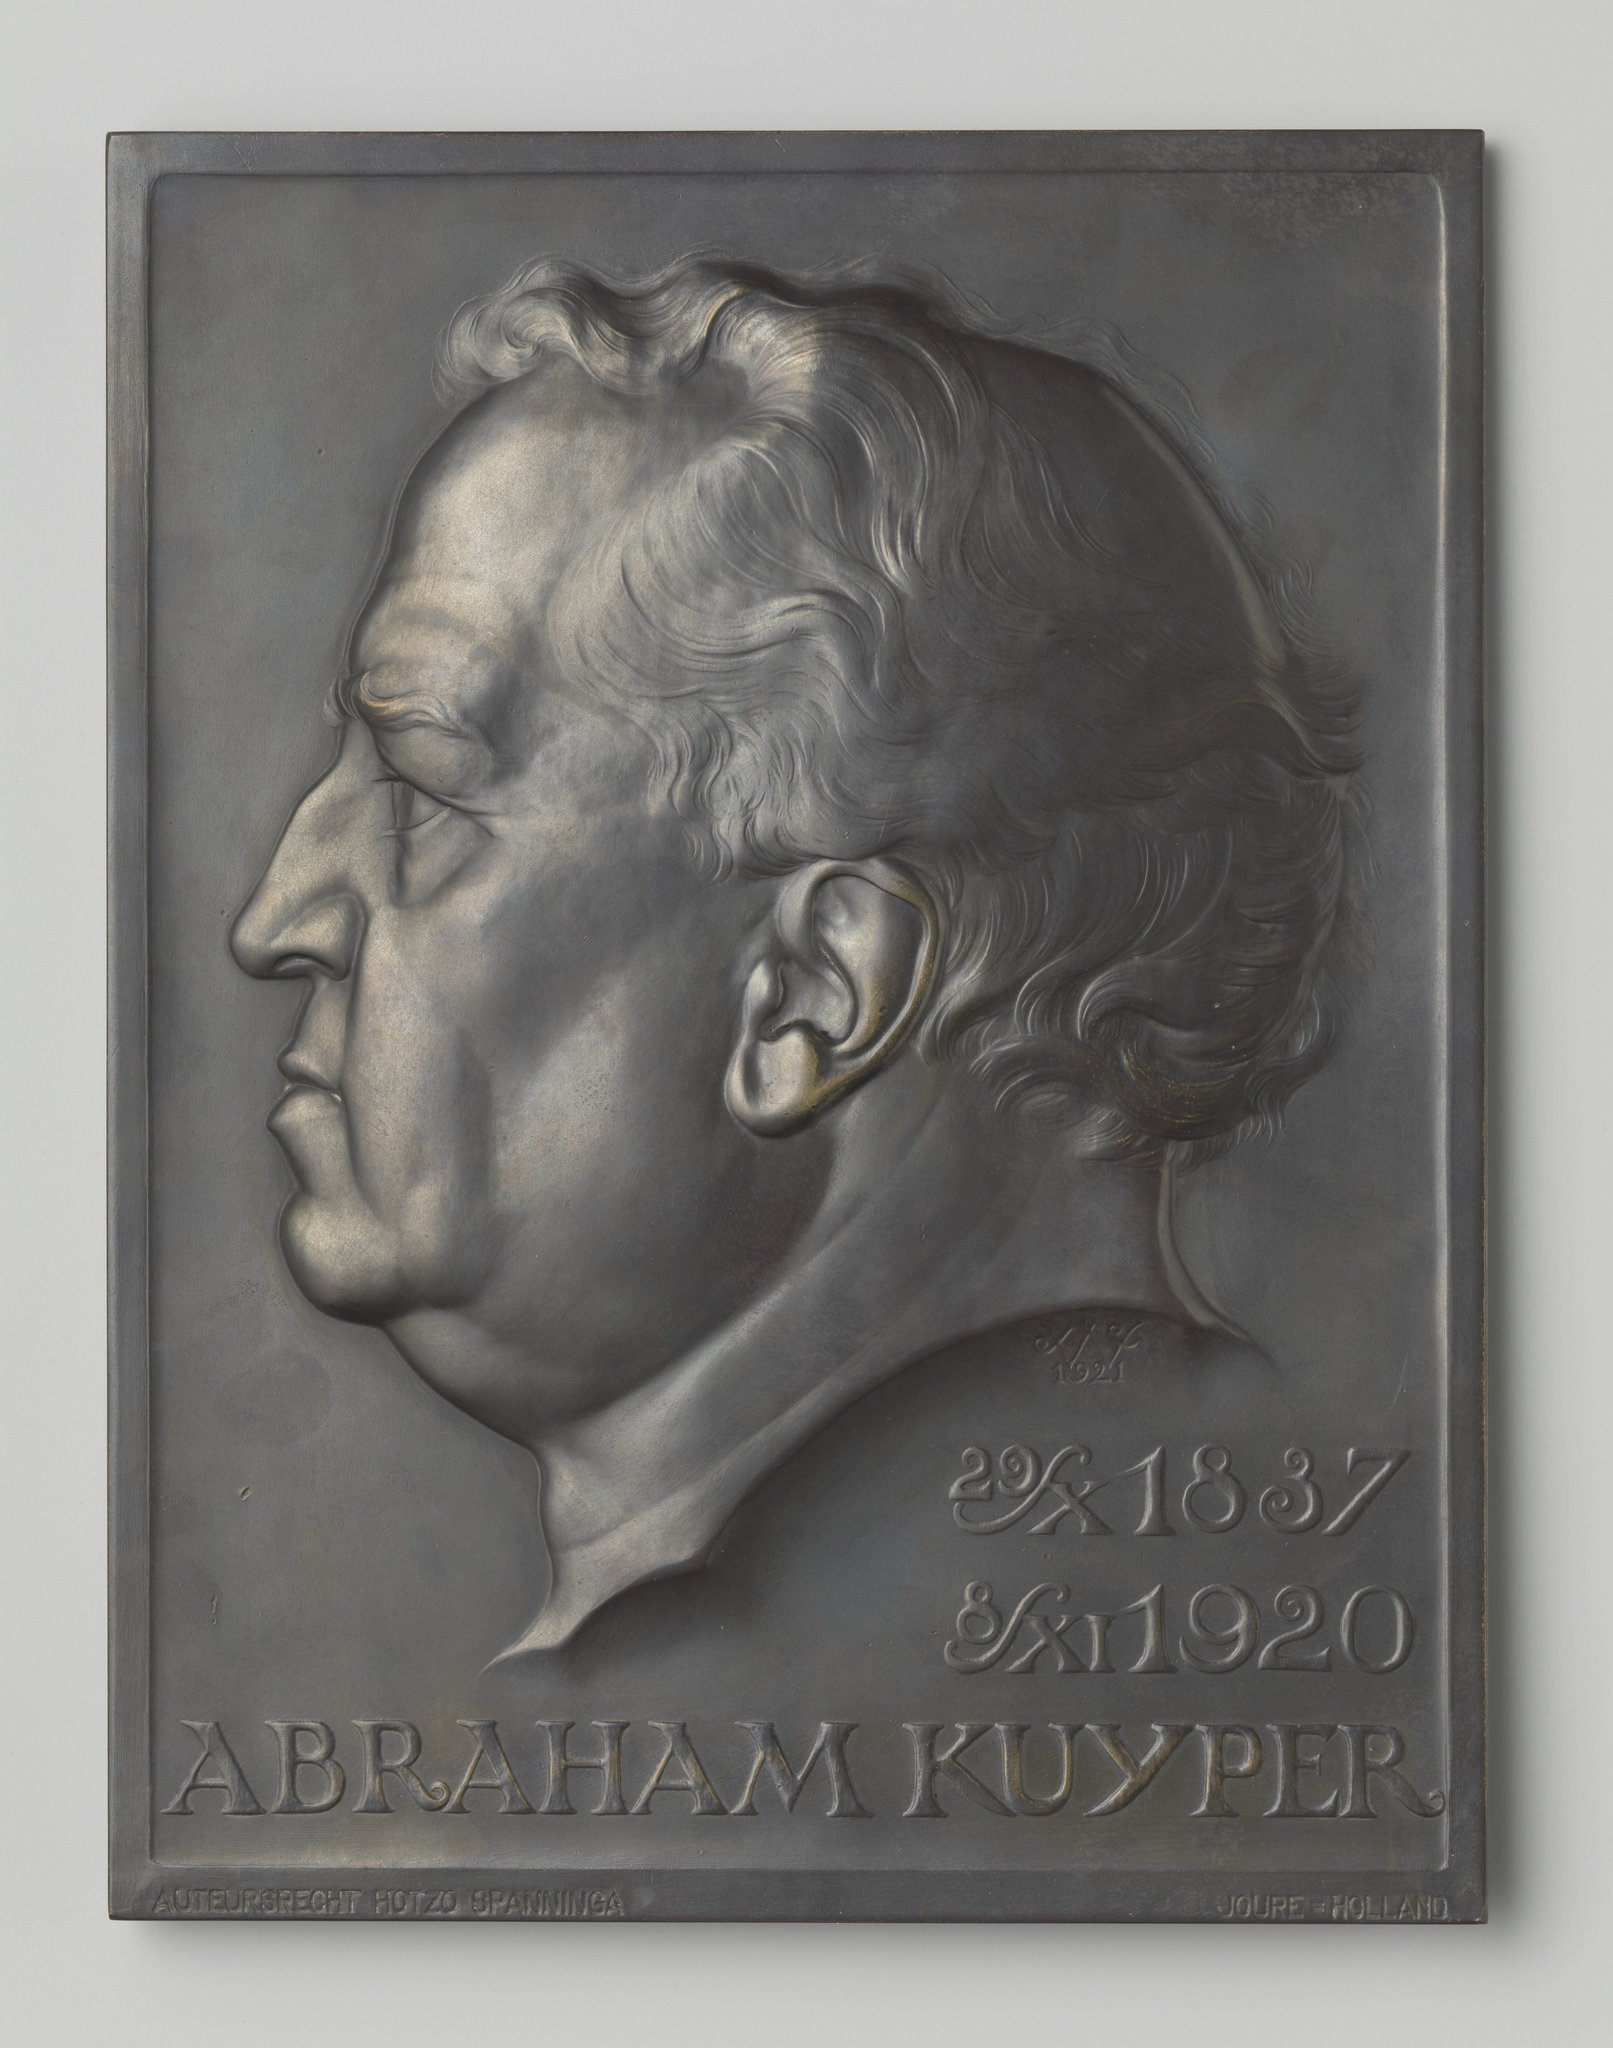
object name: plaque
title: Abraham Kuyper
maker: johannes cornelis wienecke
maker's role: medailleur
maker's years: 1872-1945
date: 1921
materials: bronze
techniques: manufacturing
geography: joure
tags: the hague, abraham kuyper, netherlands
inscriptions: inscription: ‘29 X 1837 8 XI 1920 ABRAHAM KUYPER’, monogram: ‘JCW 1921’, signature: ‘AUTEURSRECHT HOTZO SPANNINGA JOURE = HOLLAND’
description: Bronzen rechthoekige plaquette met portret van Abraham Kuyper en profile naar links. Gemerkt en opschrift. Aan de achterzijde een standaard en een ring om de plaquette op te hangen.